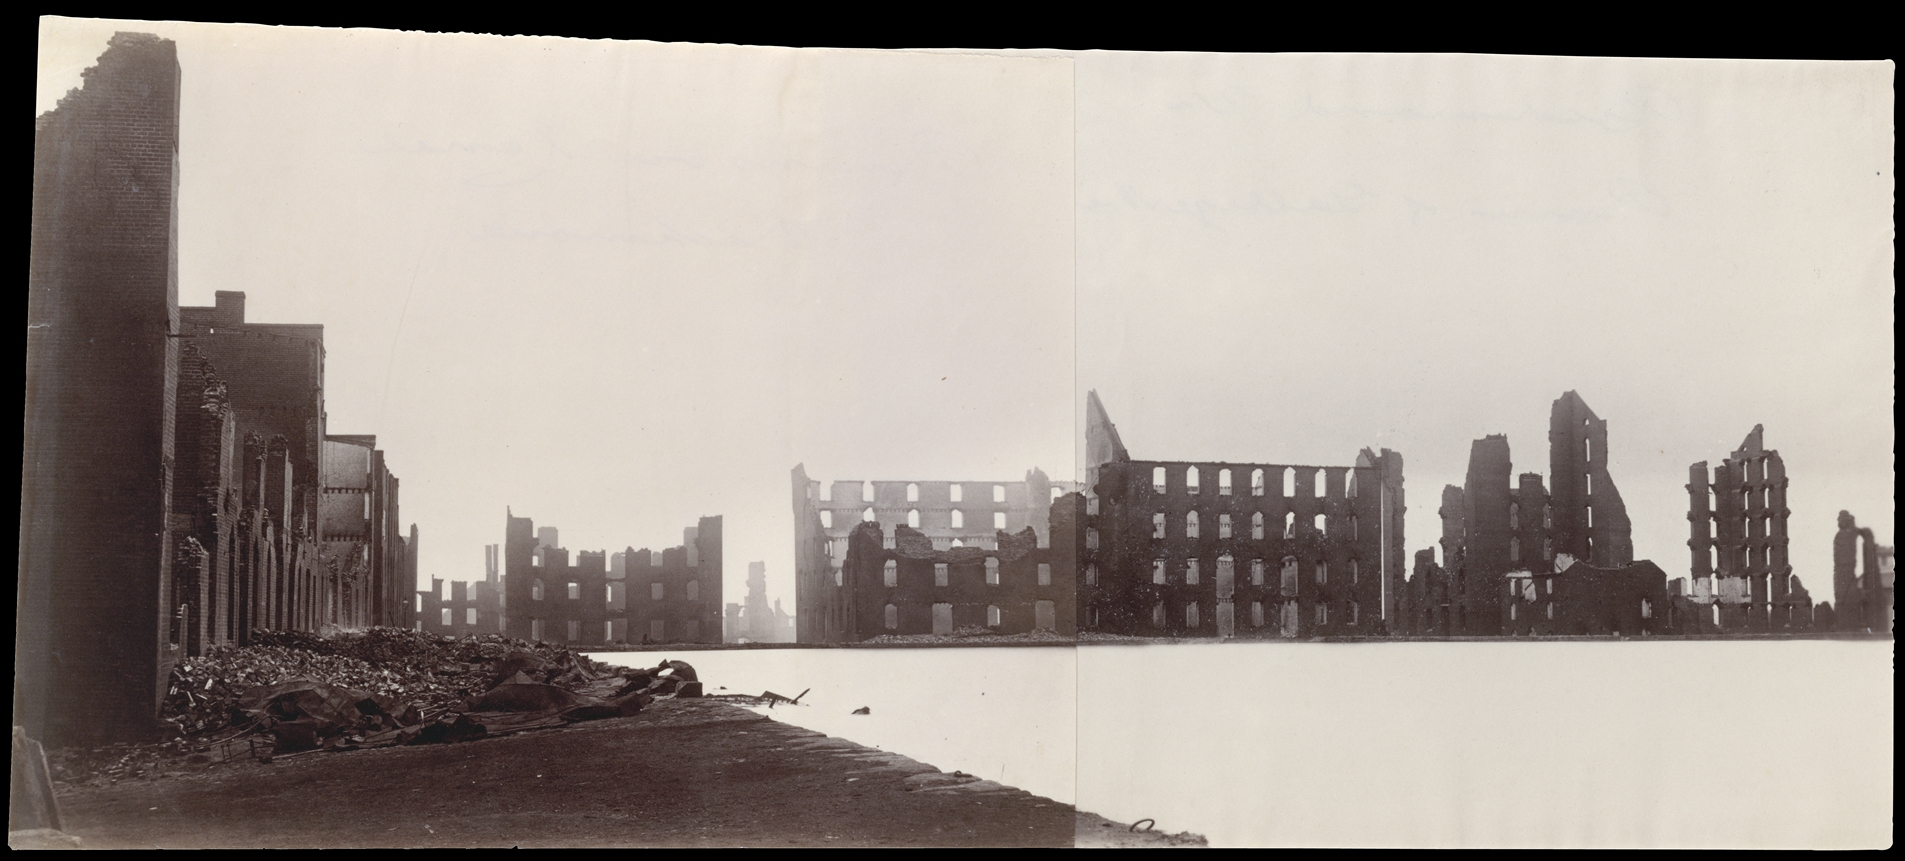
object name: panorama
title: Ruins of Gallego Flour Mills, Richmond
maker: alexander gardner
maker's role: artist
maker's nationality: american, scottish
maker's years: 1821-1882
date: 1865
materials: glass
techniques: albumen silver print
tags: buildings,american civil war